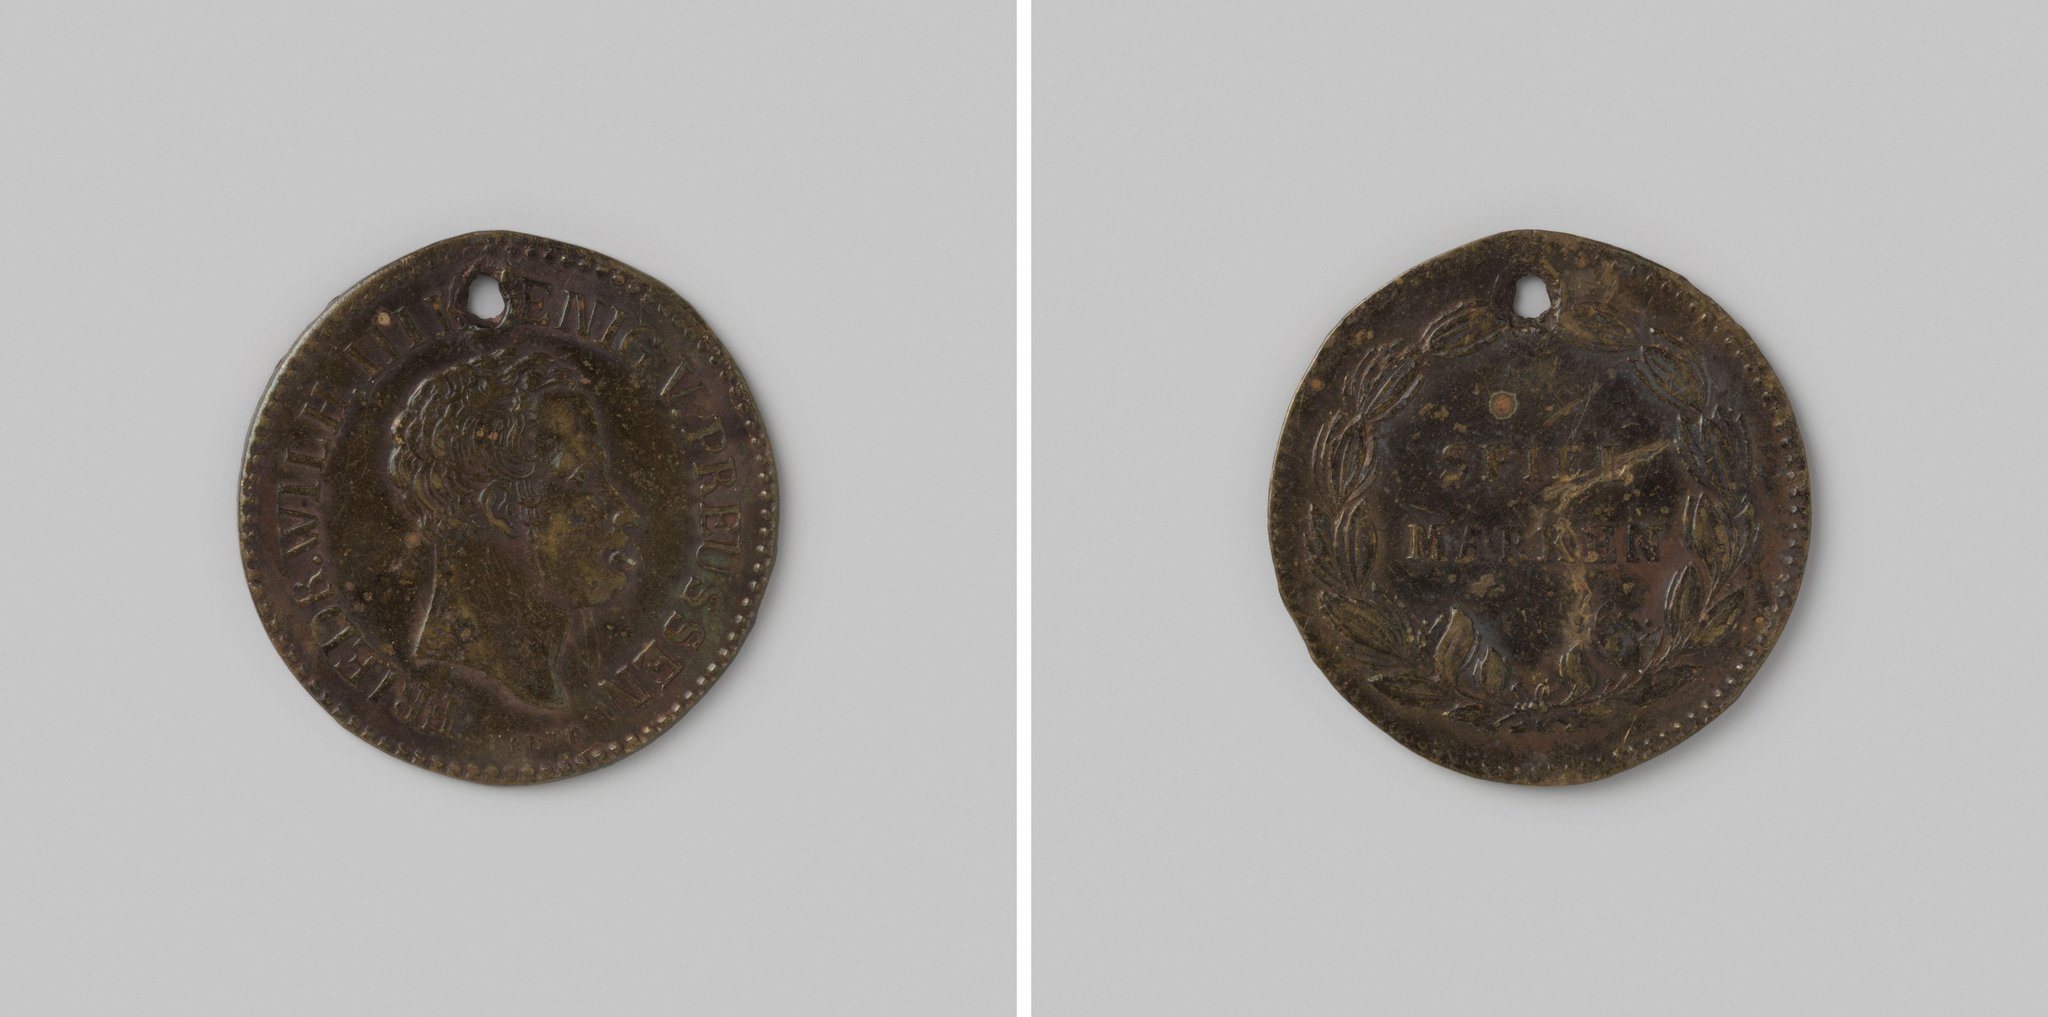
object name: gaming counter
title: Speelpenning uit Neurenberg met Koning Frederik Willem III van Pruisen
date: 1790-1810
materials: brass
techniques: striking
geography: nuremberg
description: Messing penning met doorboring, op de voorzijde het portret van Frederik Willem naar rechts met omschrift, op de keerzijde twee regels tekst tussen samengestrikte lauwertakken.